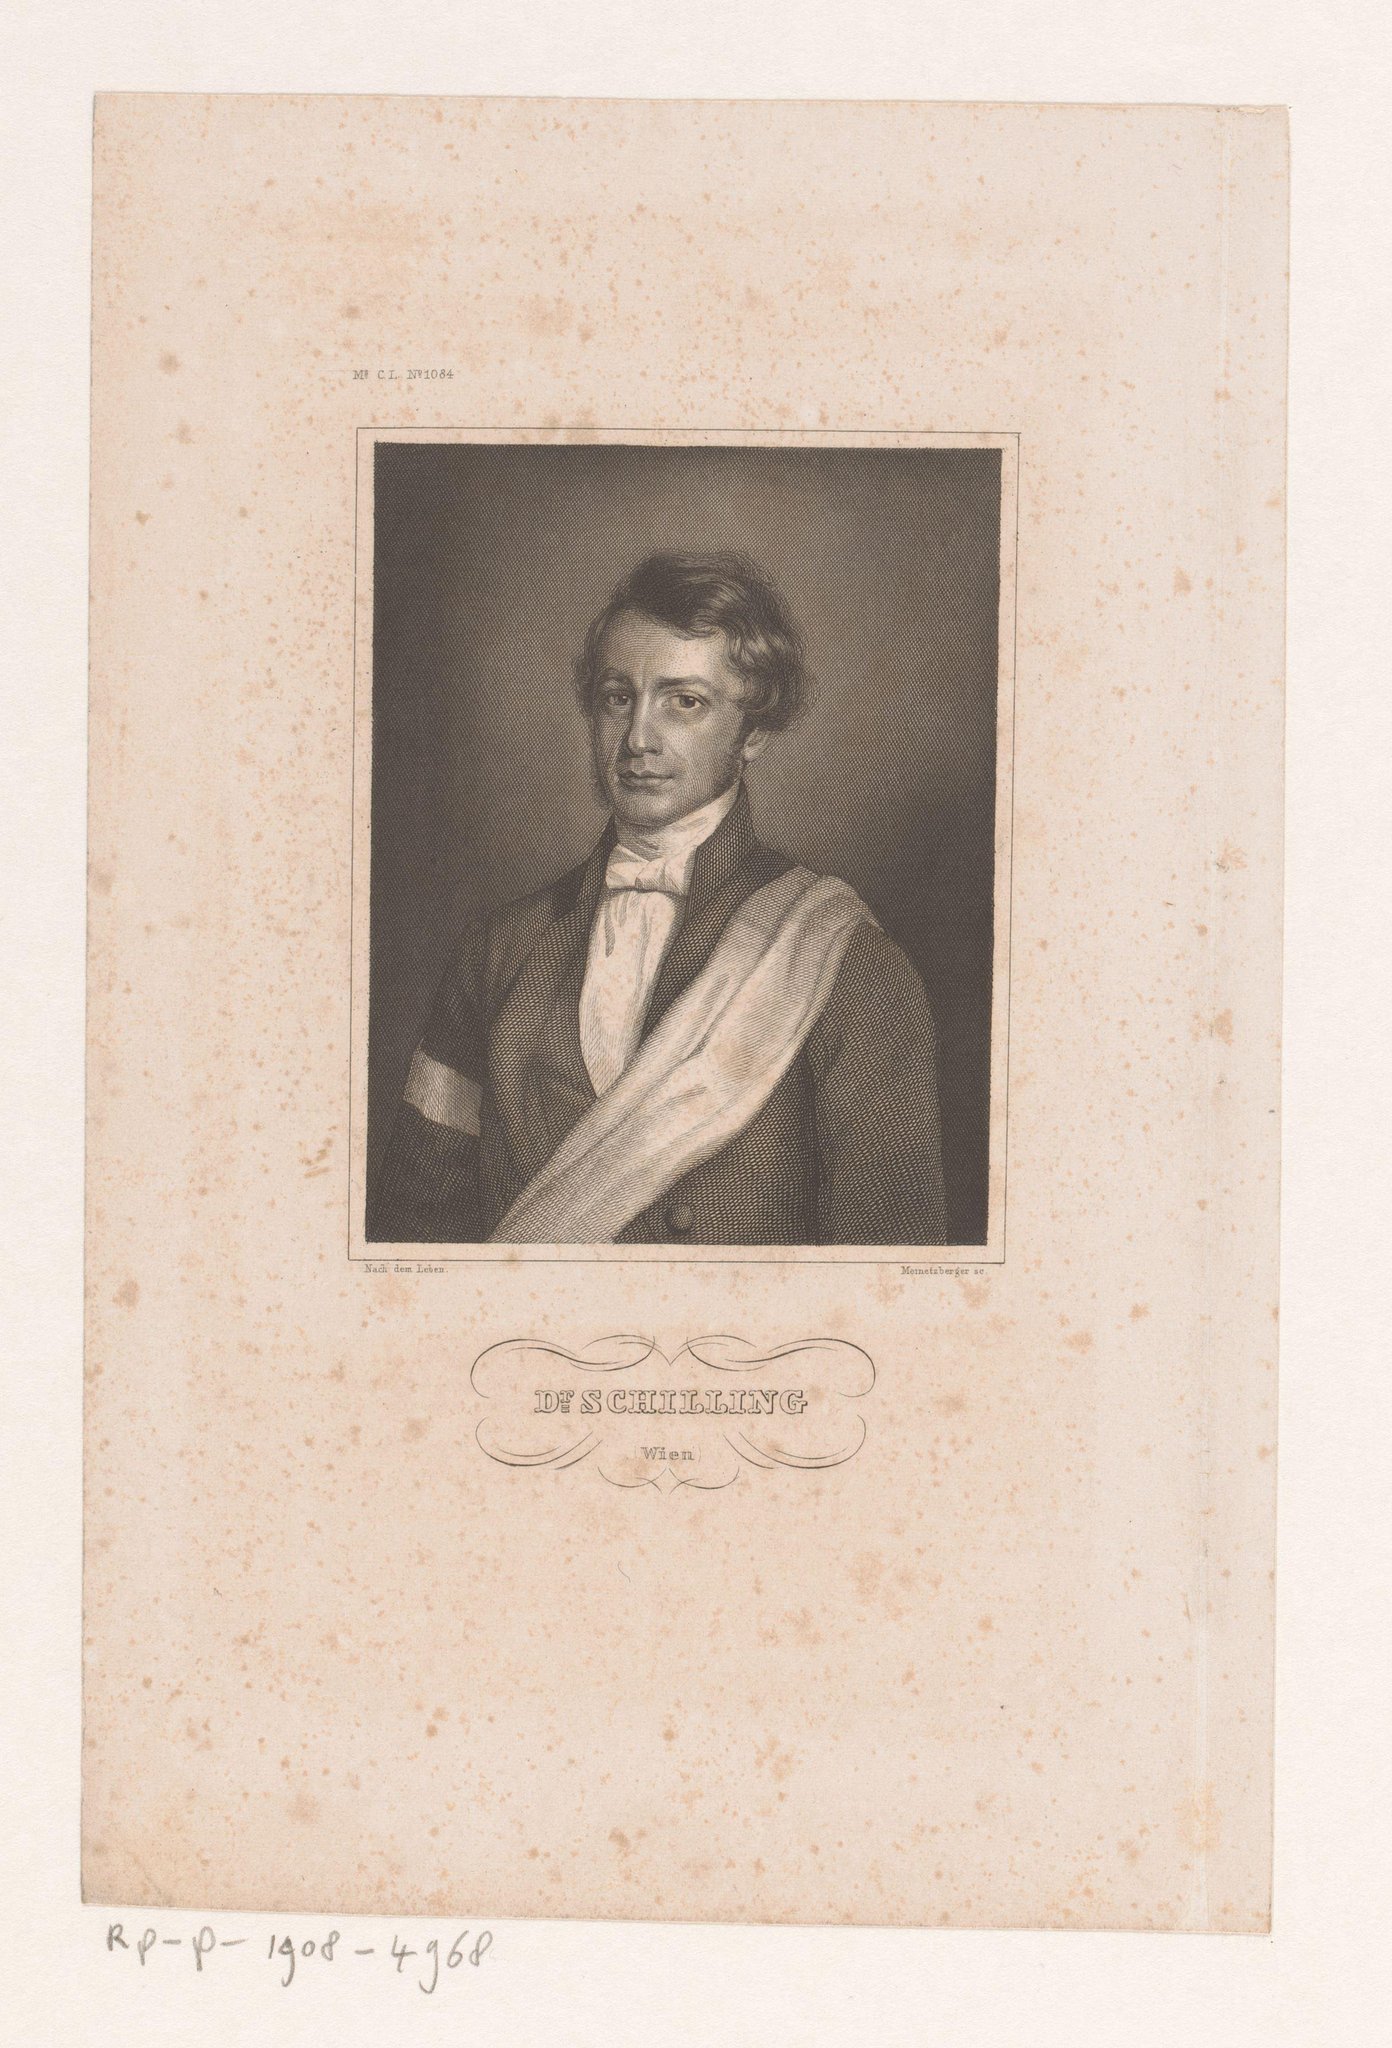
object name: book illustration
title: Portret van Dr. Schilling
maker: meinetzberger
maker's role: print maker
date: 1840-1855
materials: paper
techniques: engraving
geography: hildburghausen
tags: historical persons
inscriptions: collector's mark: Lugt 2228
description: Prent afkomstig uit: Meyer, Joseph. Das große Conversations-Lexikon für die gebildeten Stände.